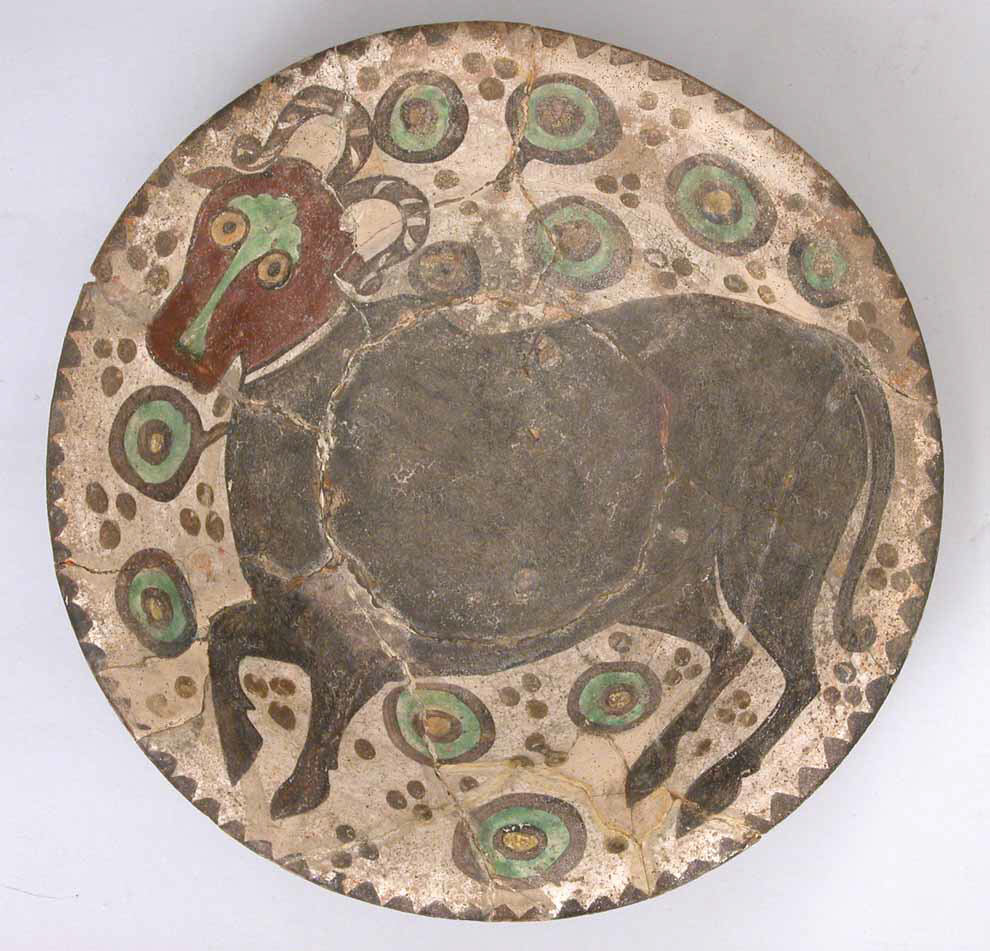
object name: bowl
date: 901-1000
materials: earthenware, glaze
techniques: painting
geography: iran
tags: animals